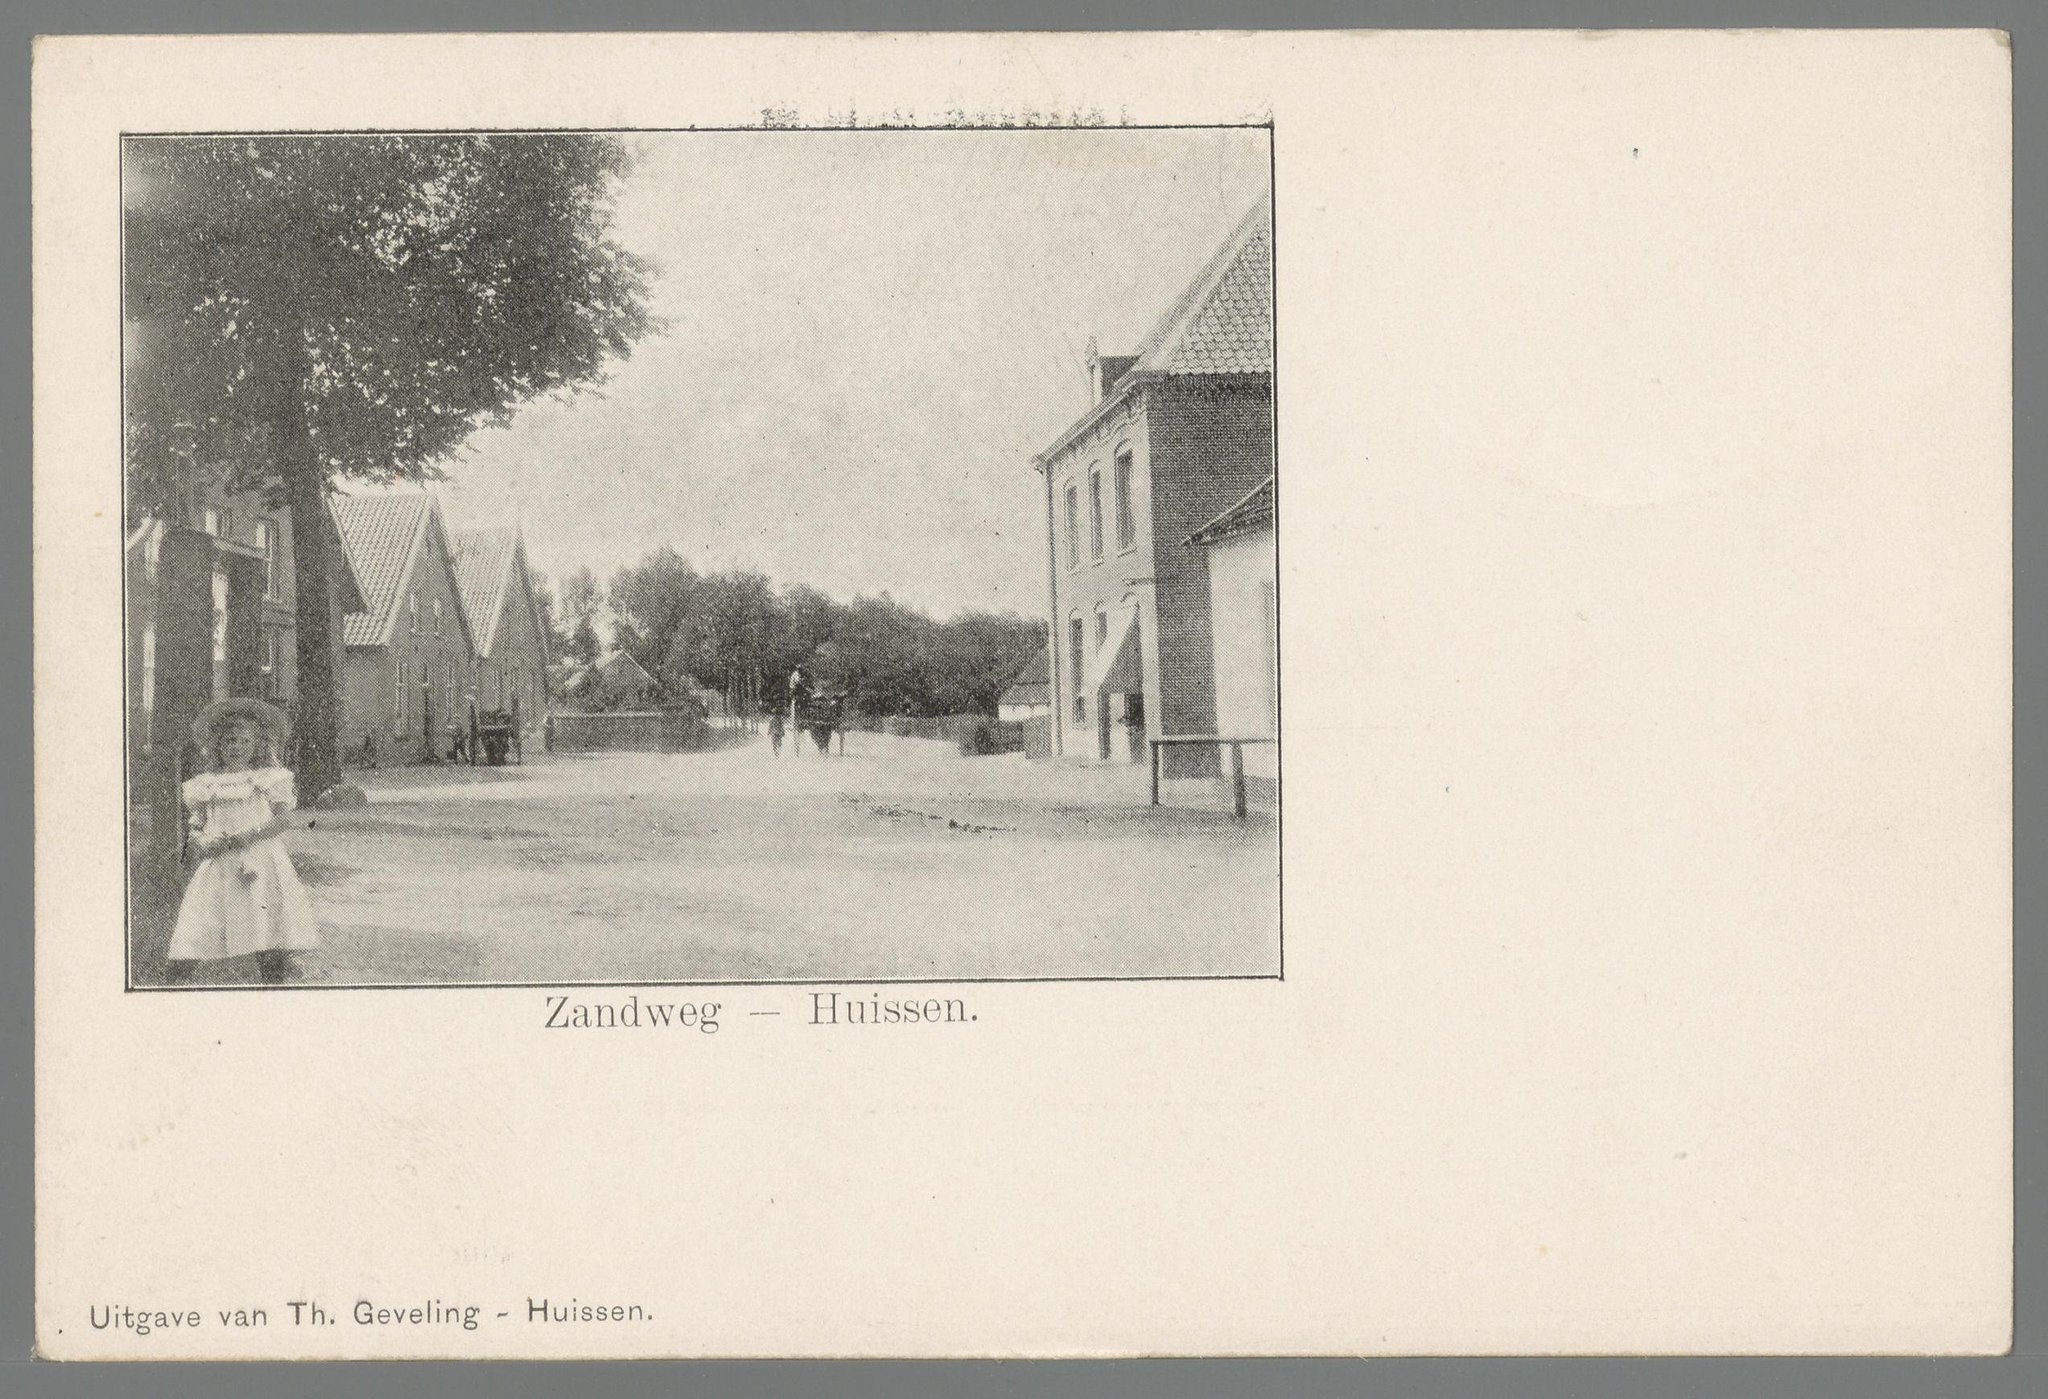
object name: photomechanical print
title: Zandweg - Huissen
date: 1892-1905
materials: cardboard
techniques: autotype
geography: huissen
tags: street